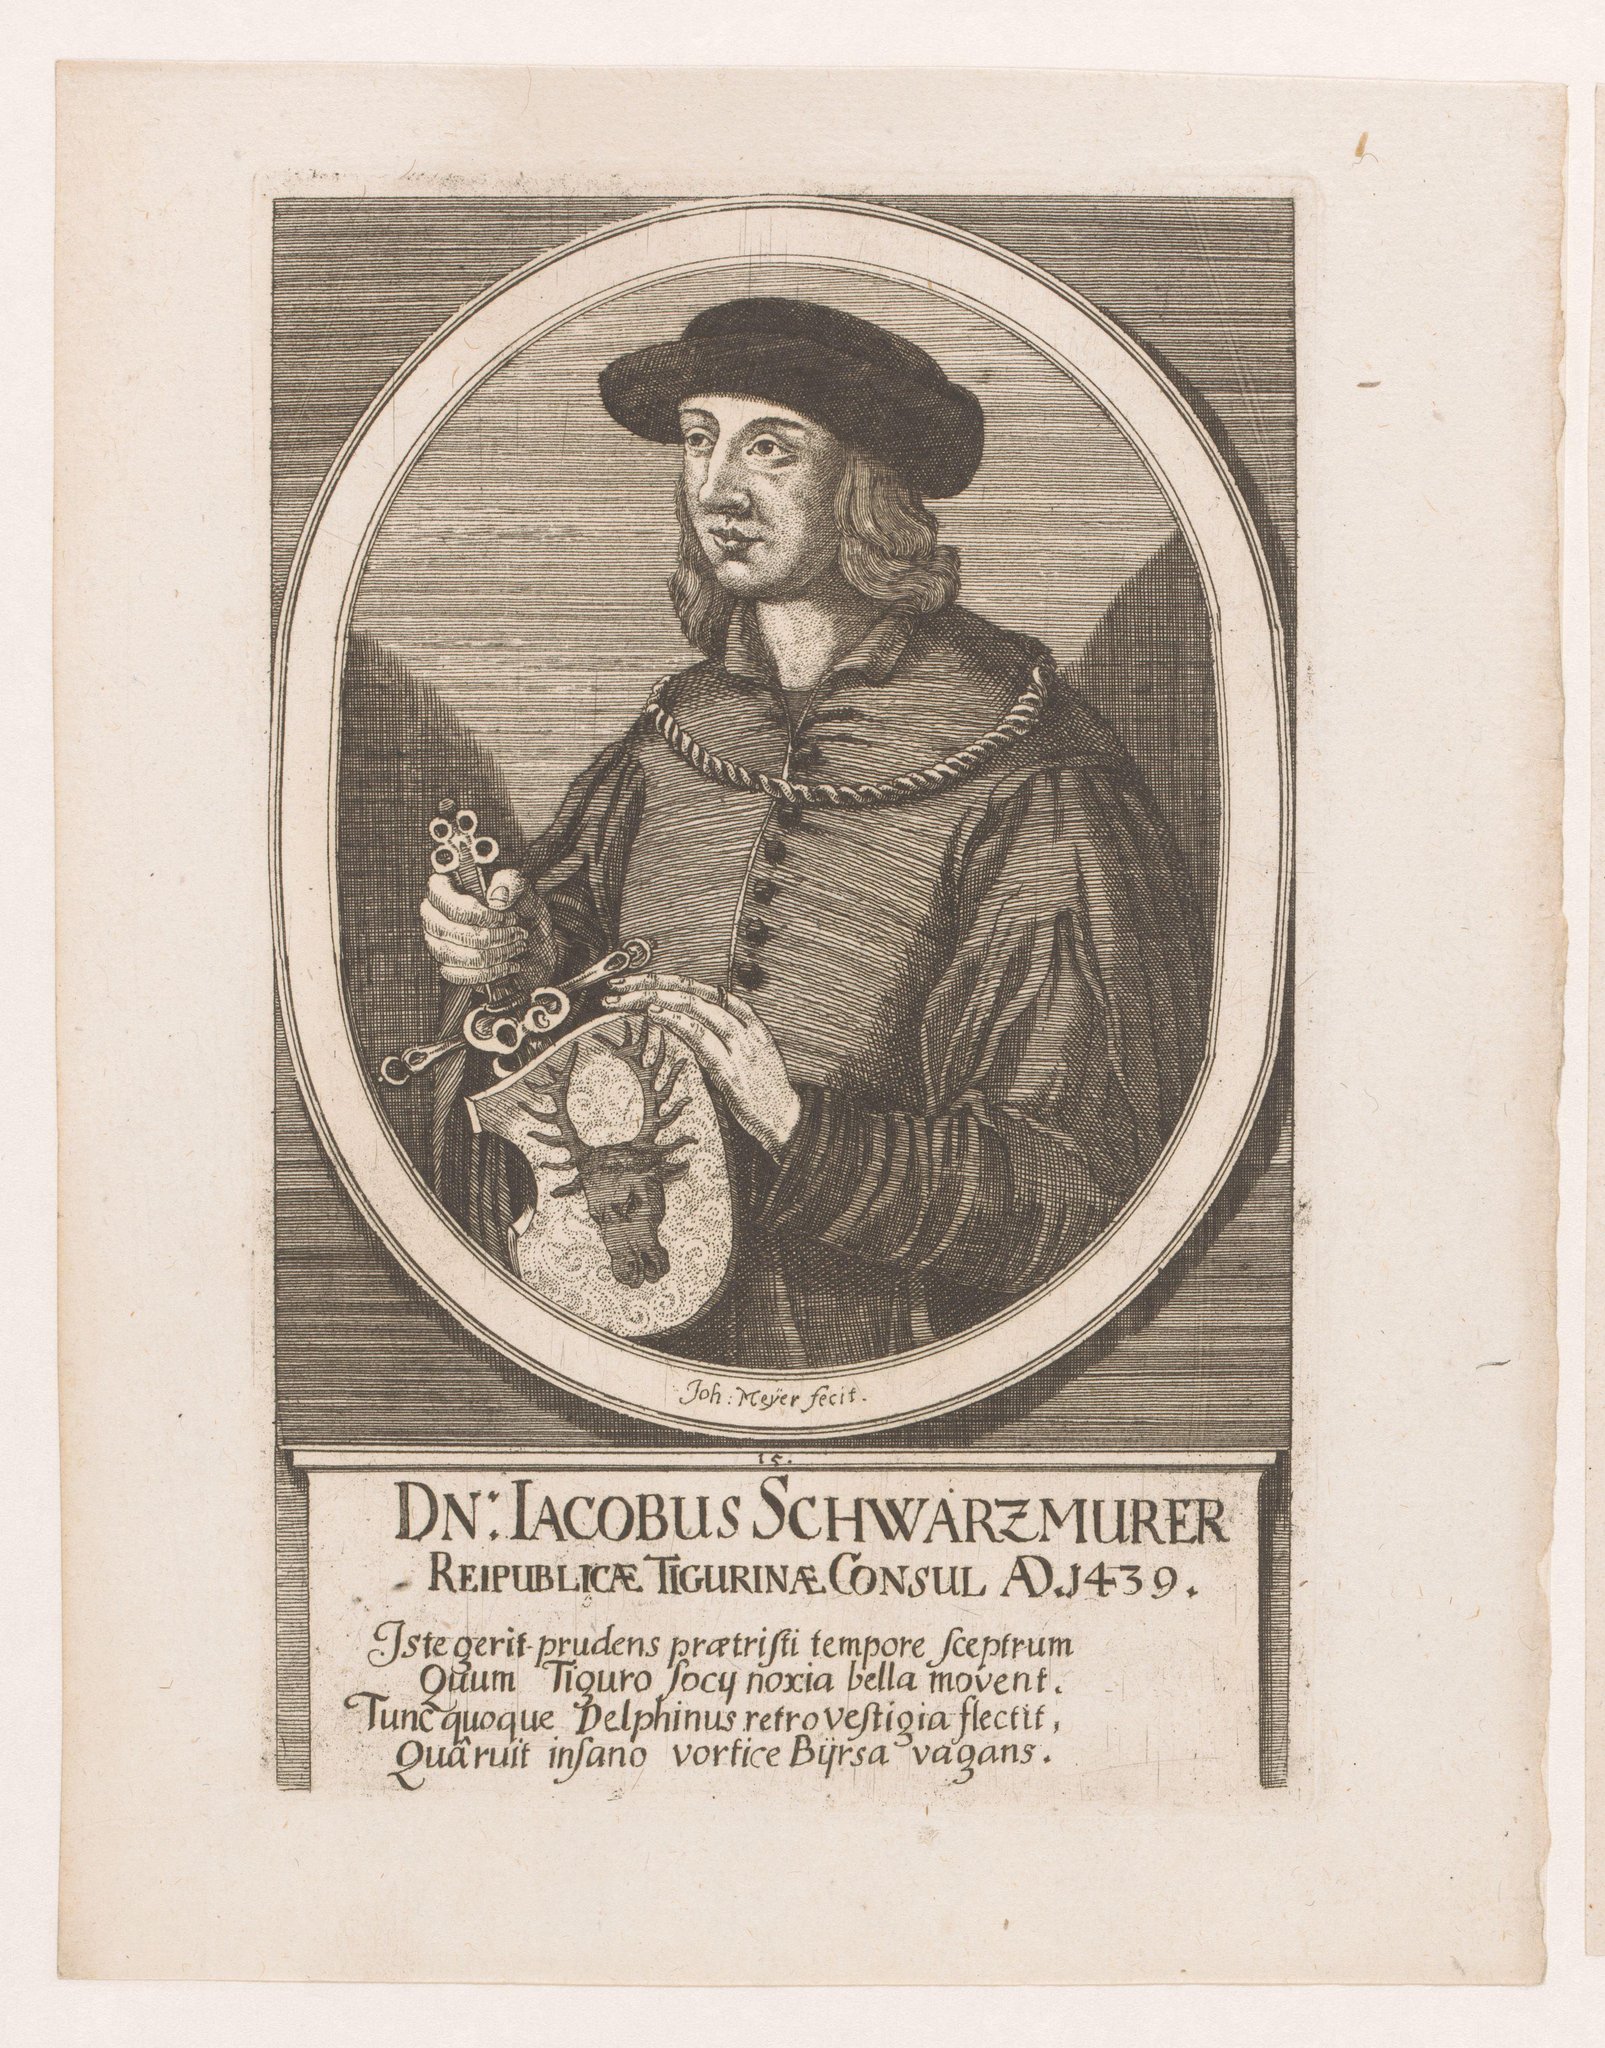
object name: print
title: Portret van Jakob Schwarzmurer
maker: johannes meyer (ii)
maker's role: print maker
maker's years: 1655-1712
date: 1665-1712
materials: paper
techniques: engraving, etching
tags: mayor, burgomaster, historical persons, hacking and thrusting weapons: sword, armorial bearing, heraldry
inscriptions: collector's mark: Lugt 2228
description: Onderaan de ovale omlijsting genummerd: 15.